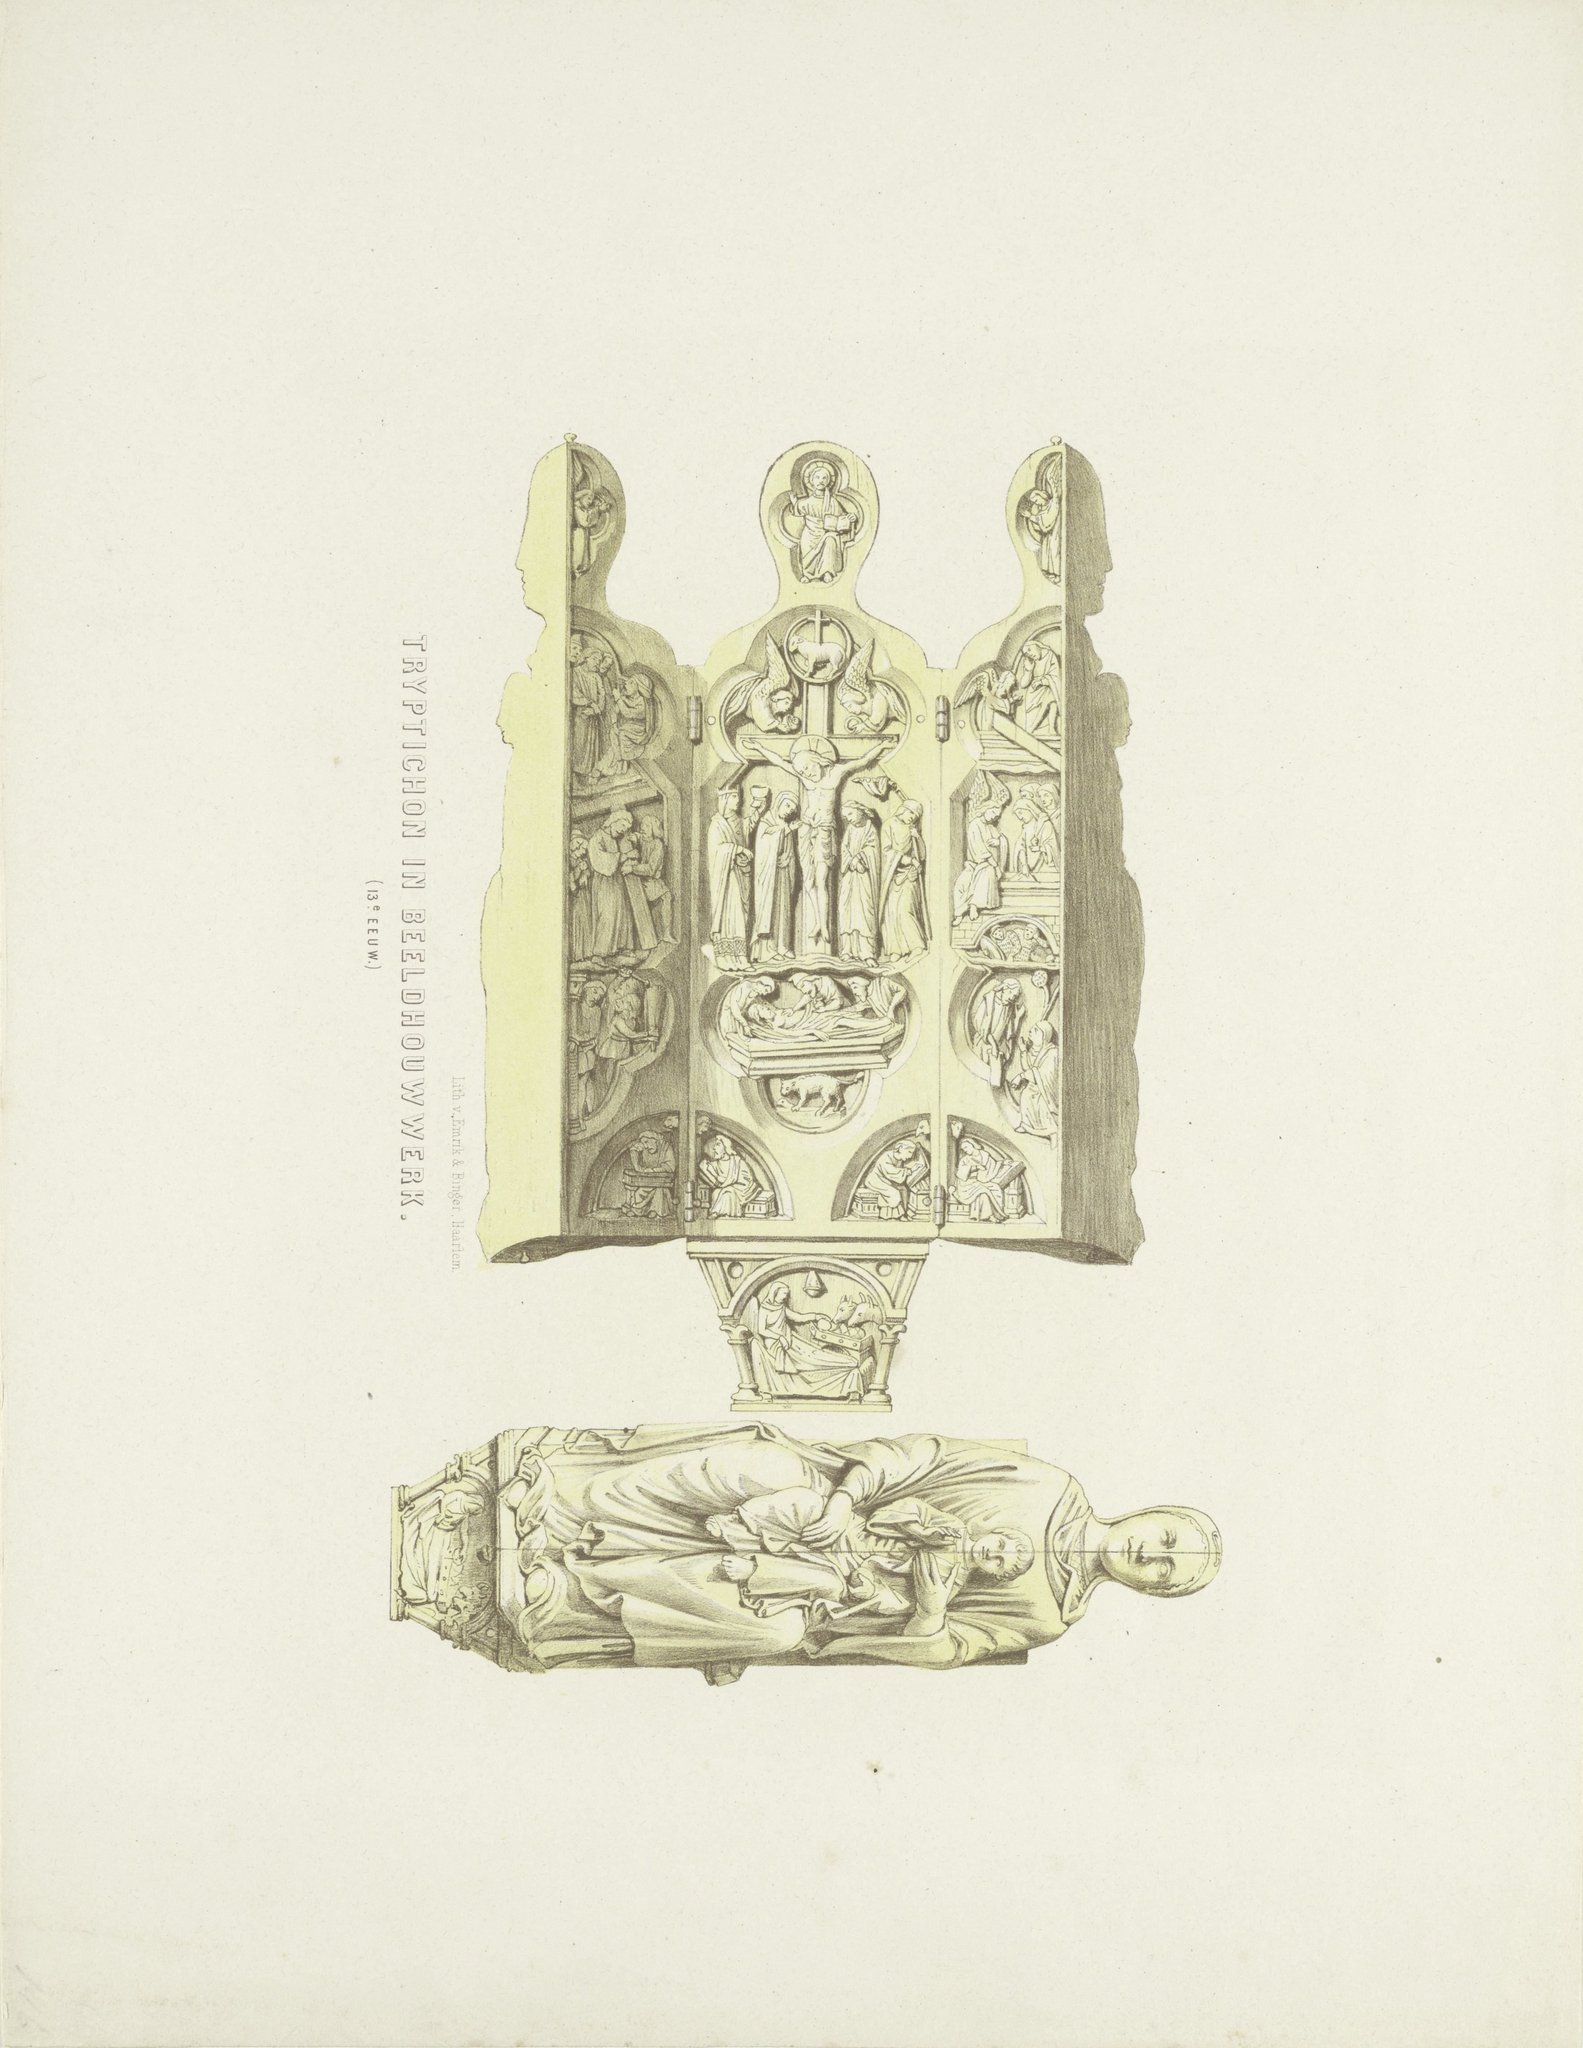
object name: historical object representation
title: Tryptichon in beeldhouwwerk. (13e eeuw)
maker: Anonymous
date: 1857-1864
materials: paper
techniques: tone lithography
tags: piece of sculpture, reproduction of a piece of sculpture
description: Illustratie voor: W.J. Hofdijk, Ons voorgeslacht in zijn dagelyksch leven geschilderd, Kruseman, Haarlem 1859-1864.